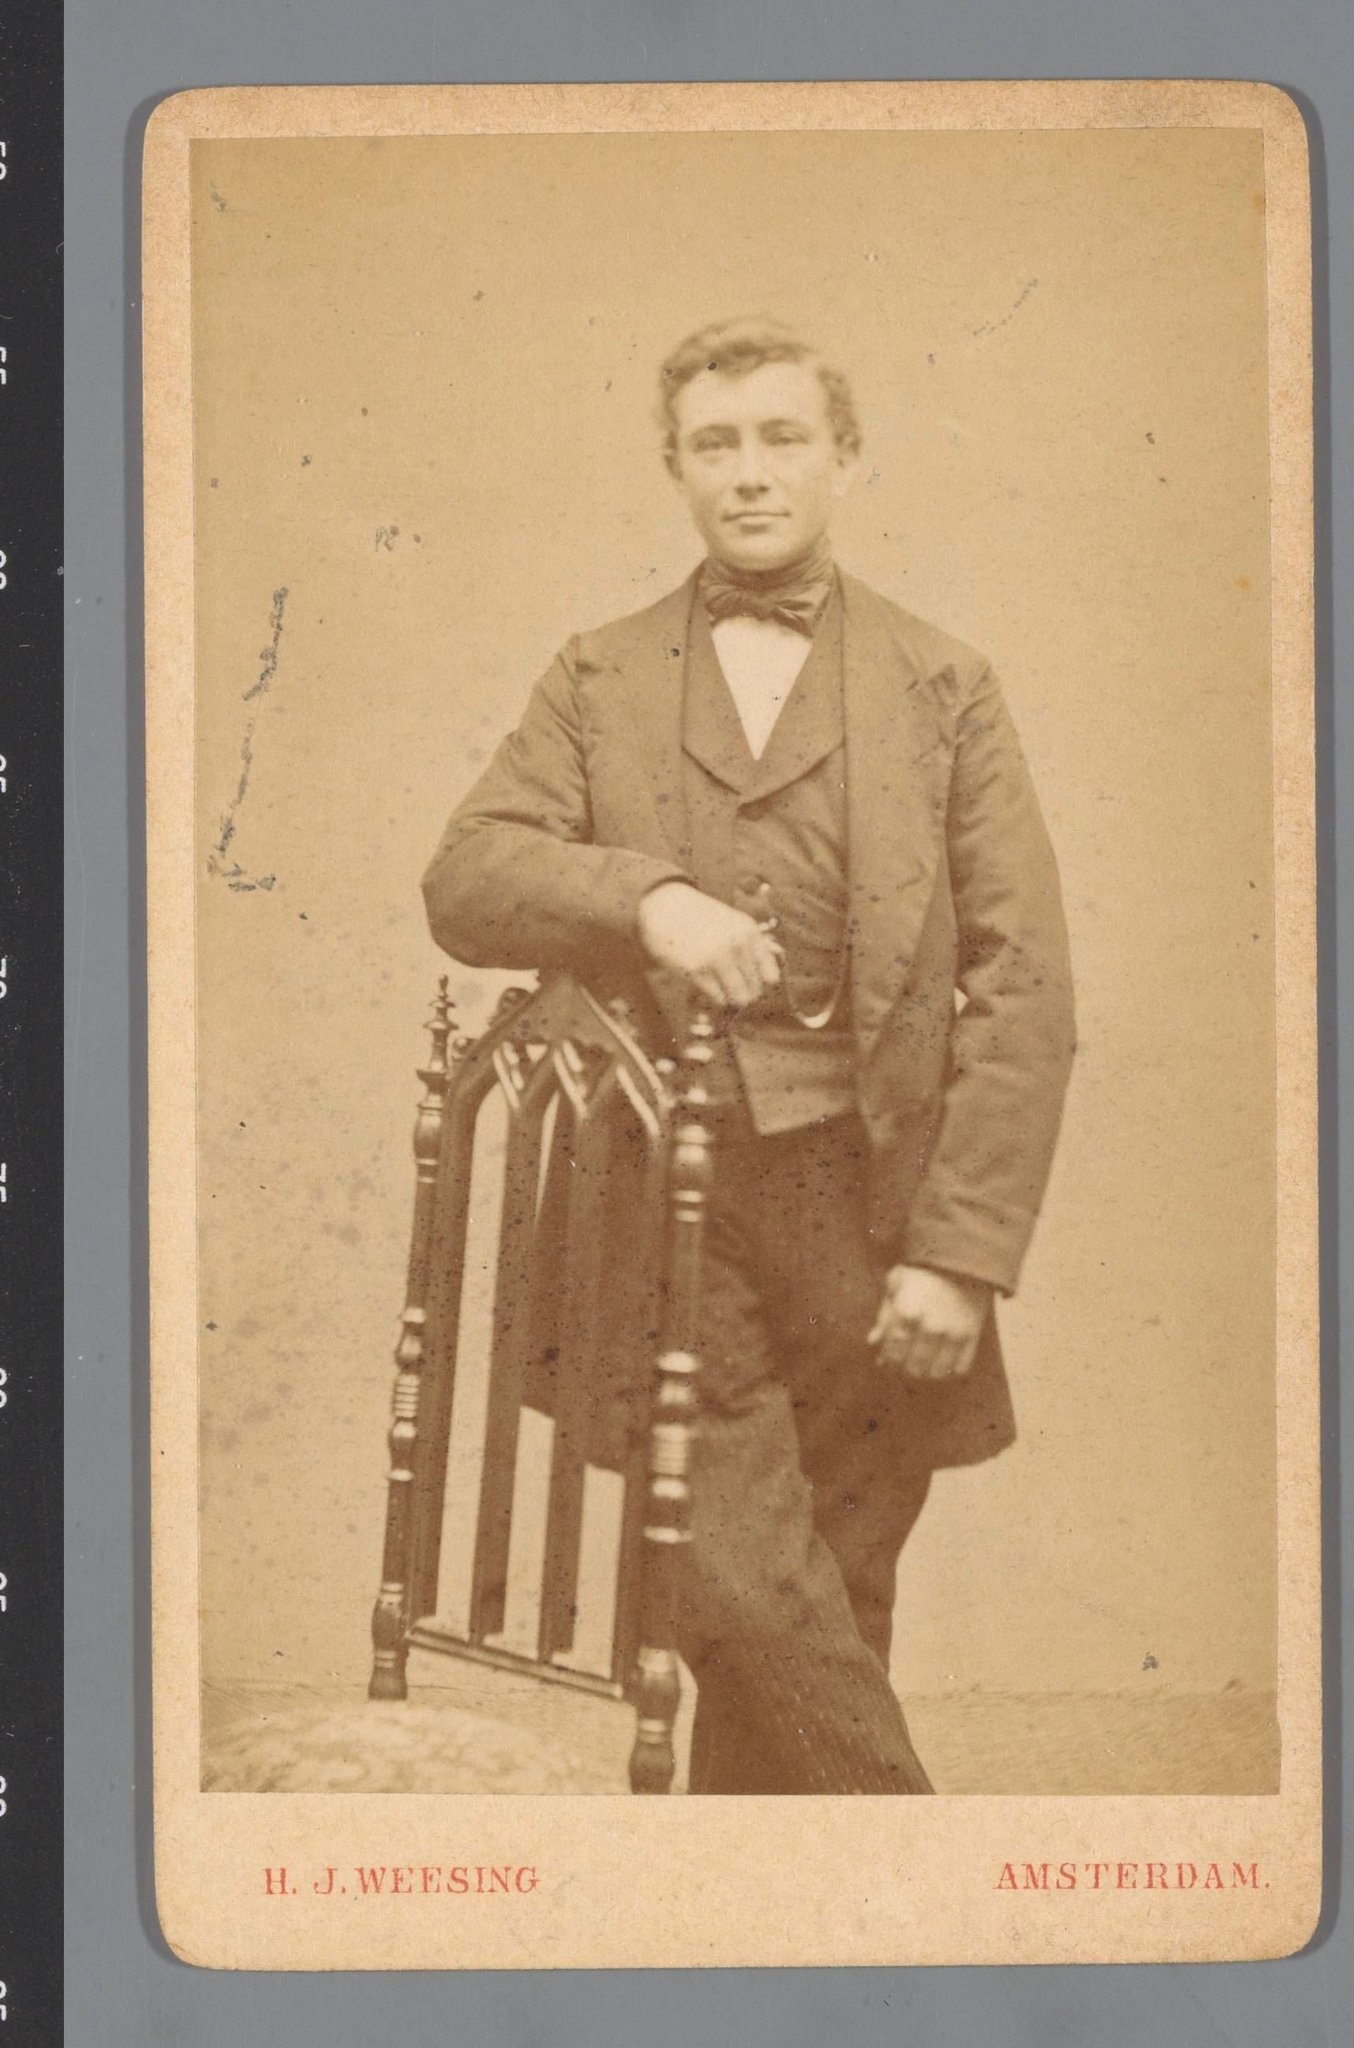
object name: carte de visite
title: Portret van een jonge man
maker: hermanus jodocus weesing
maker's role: fotograaf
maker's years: 1844-1910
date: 1860-1880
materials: cardboard, paper, photographic support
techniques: albumen print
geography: amsterdam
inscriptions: address: ‘H.J. WEESING // Photograaf // BINNEN BREOUWRSTRAAT // TT.220, // AMSTERDAM.’, address: ‘H.J. WEESING AMSTERDAM’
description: Portret van een jonge man, staand naast een stoel, met zijn arm op de rugleuning.